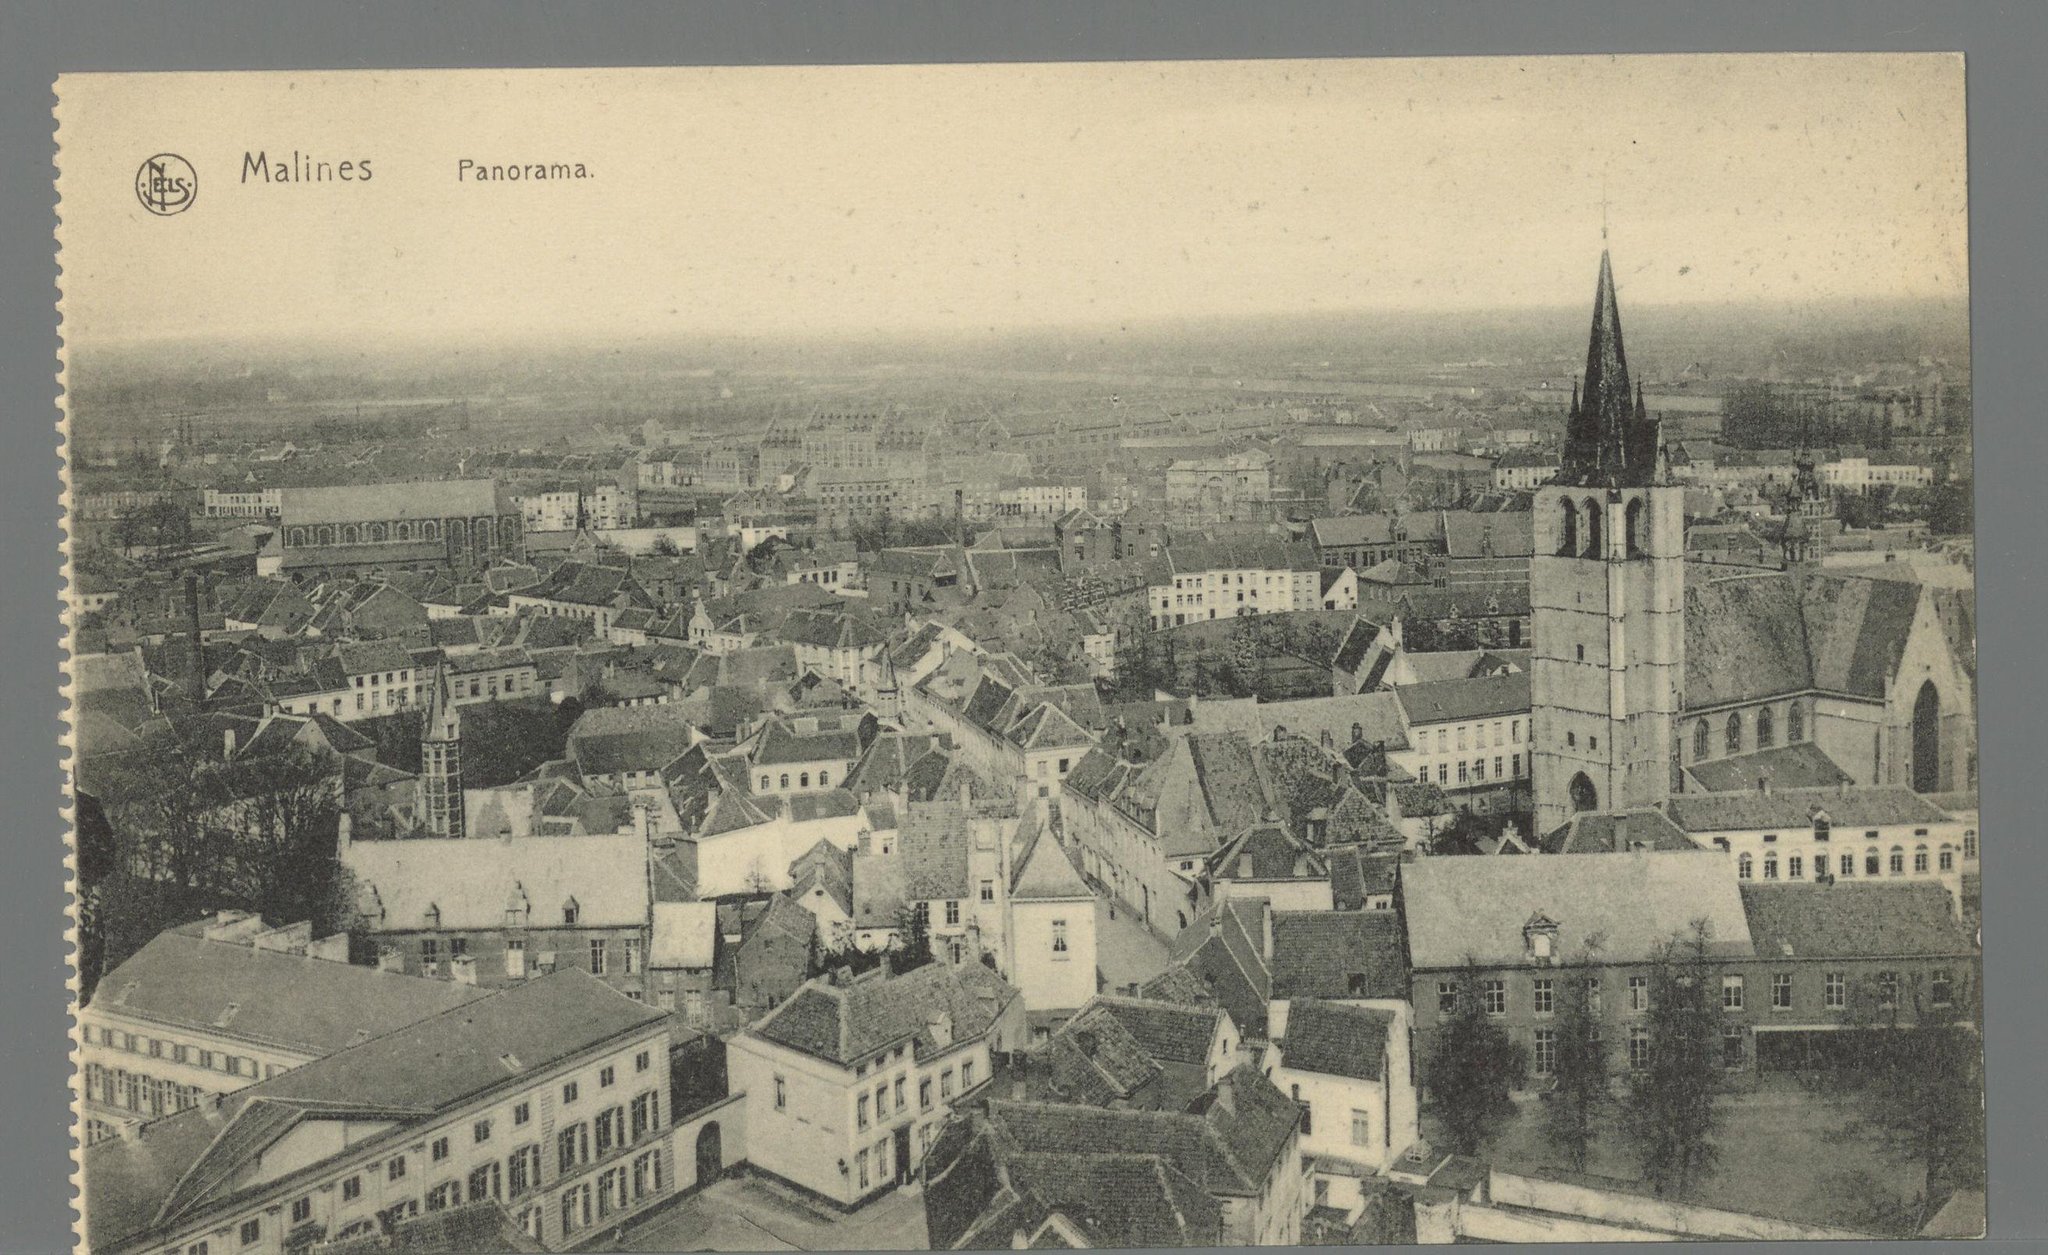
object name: ansichtkaart, prentbriefkaart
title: Malines. Panorama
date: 1913-1914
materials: cardboard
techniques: photograph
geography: brussels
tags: church (exterior), prospect of city, town panorama, silhouette of city, mechelen